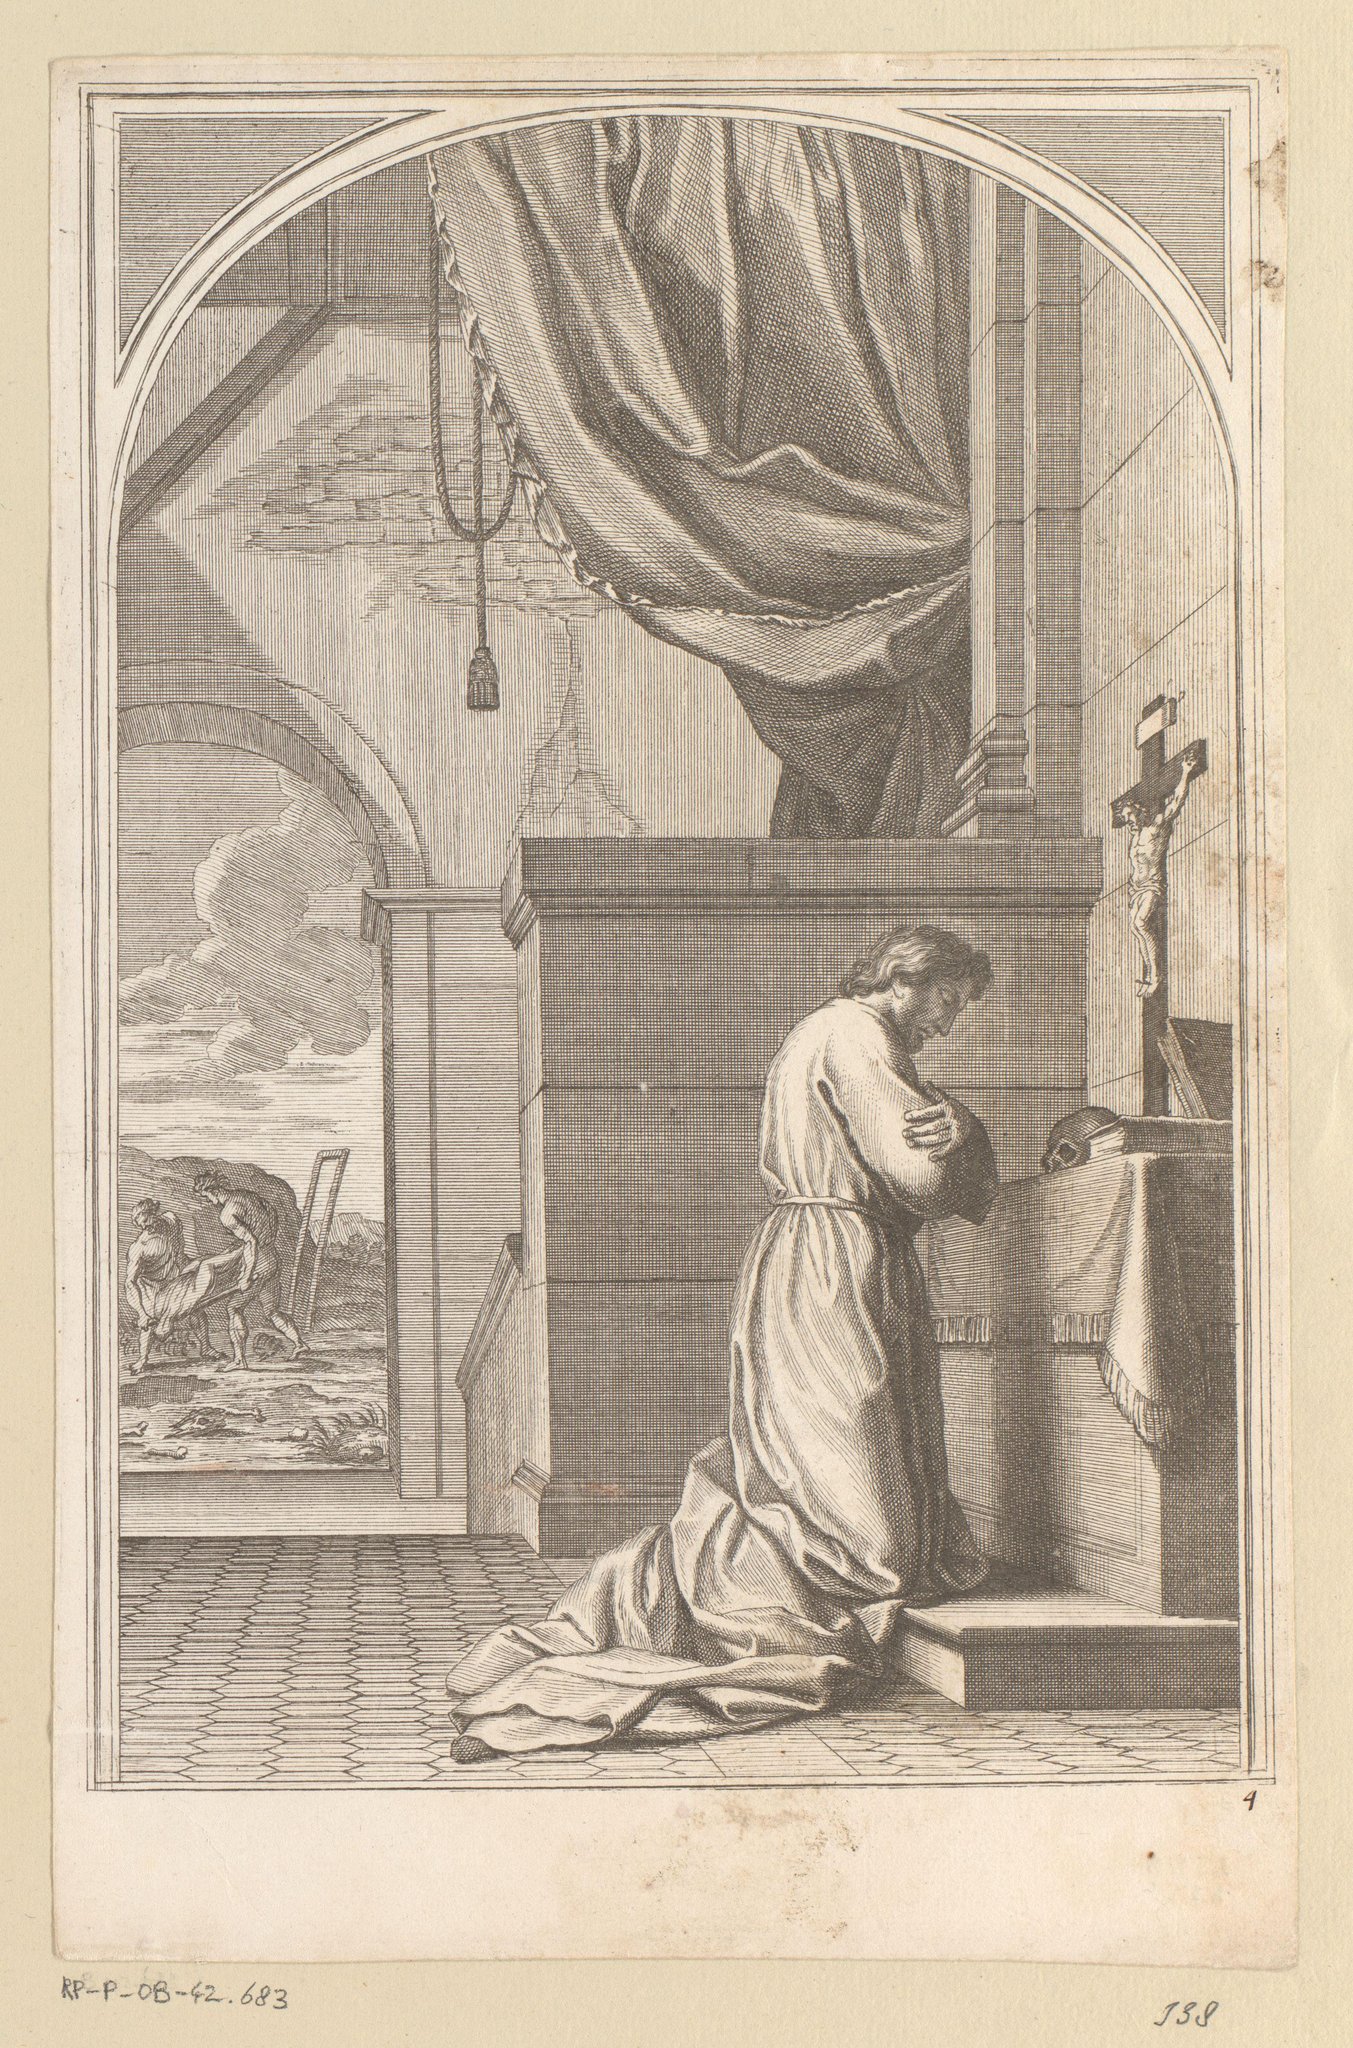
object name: print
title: Heilige Bruno in gebed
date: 1623-1676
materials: paper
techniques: printmaking, engraving, etching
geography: france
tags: the founder of the order of the carthusians, bruno; possible attributes: cross, finger at lips, lily, mitre at his feet, olive-branch, ray of light, skull, (seven) star(s), personal devotion of st. bruno - male saint meditating, in ecstasy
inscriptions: collector's mark: Lugt 2165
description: Maakt deel uit van een serie met 24 prenten (inclusief twee titelprenten), naar schilderijen door Lesueur vervaardigd tussen 1645-1648 voor de Chartreuse de Paris. De serie is getiteld: La vie de St. Bruno fondateur de l'Ordre des Chartreux peinte au cloistre de la Chartreuse de Paris par Eustache Le Sueur.